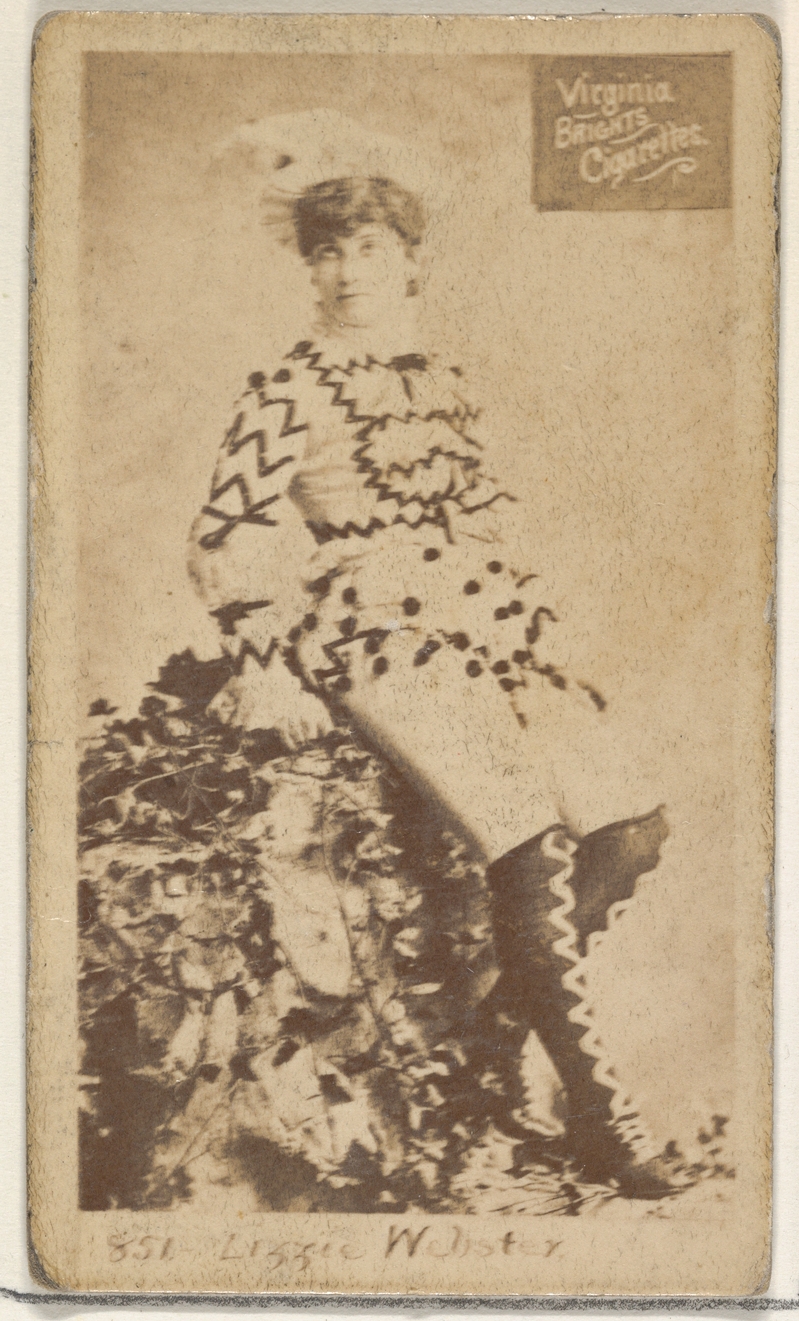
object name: photograph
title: Card 851, Lizzie Webster, from the Actors and Actresses series (N45, Type 2) for Virginia Brights Cigarettes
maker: allen & ginter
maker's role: publisher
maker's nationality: american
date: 1888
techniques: albumen silver print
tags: portraits,women,actresses